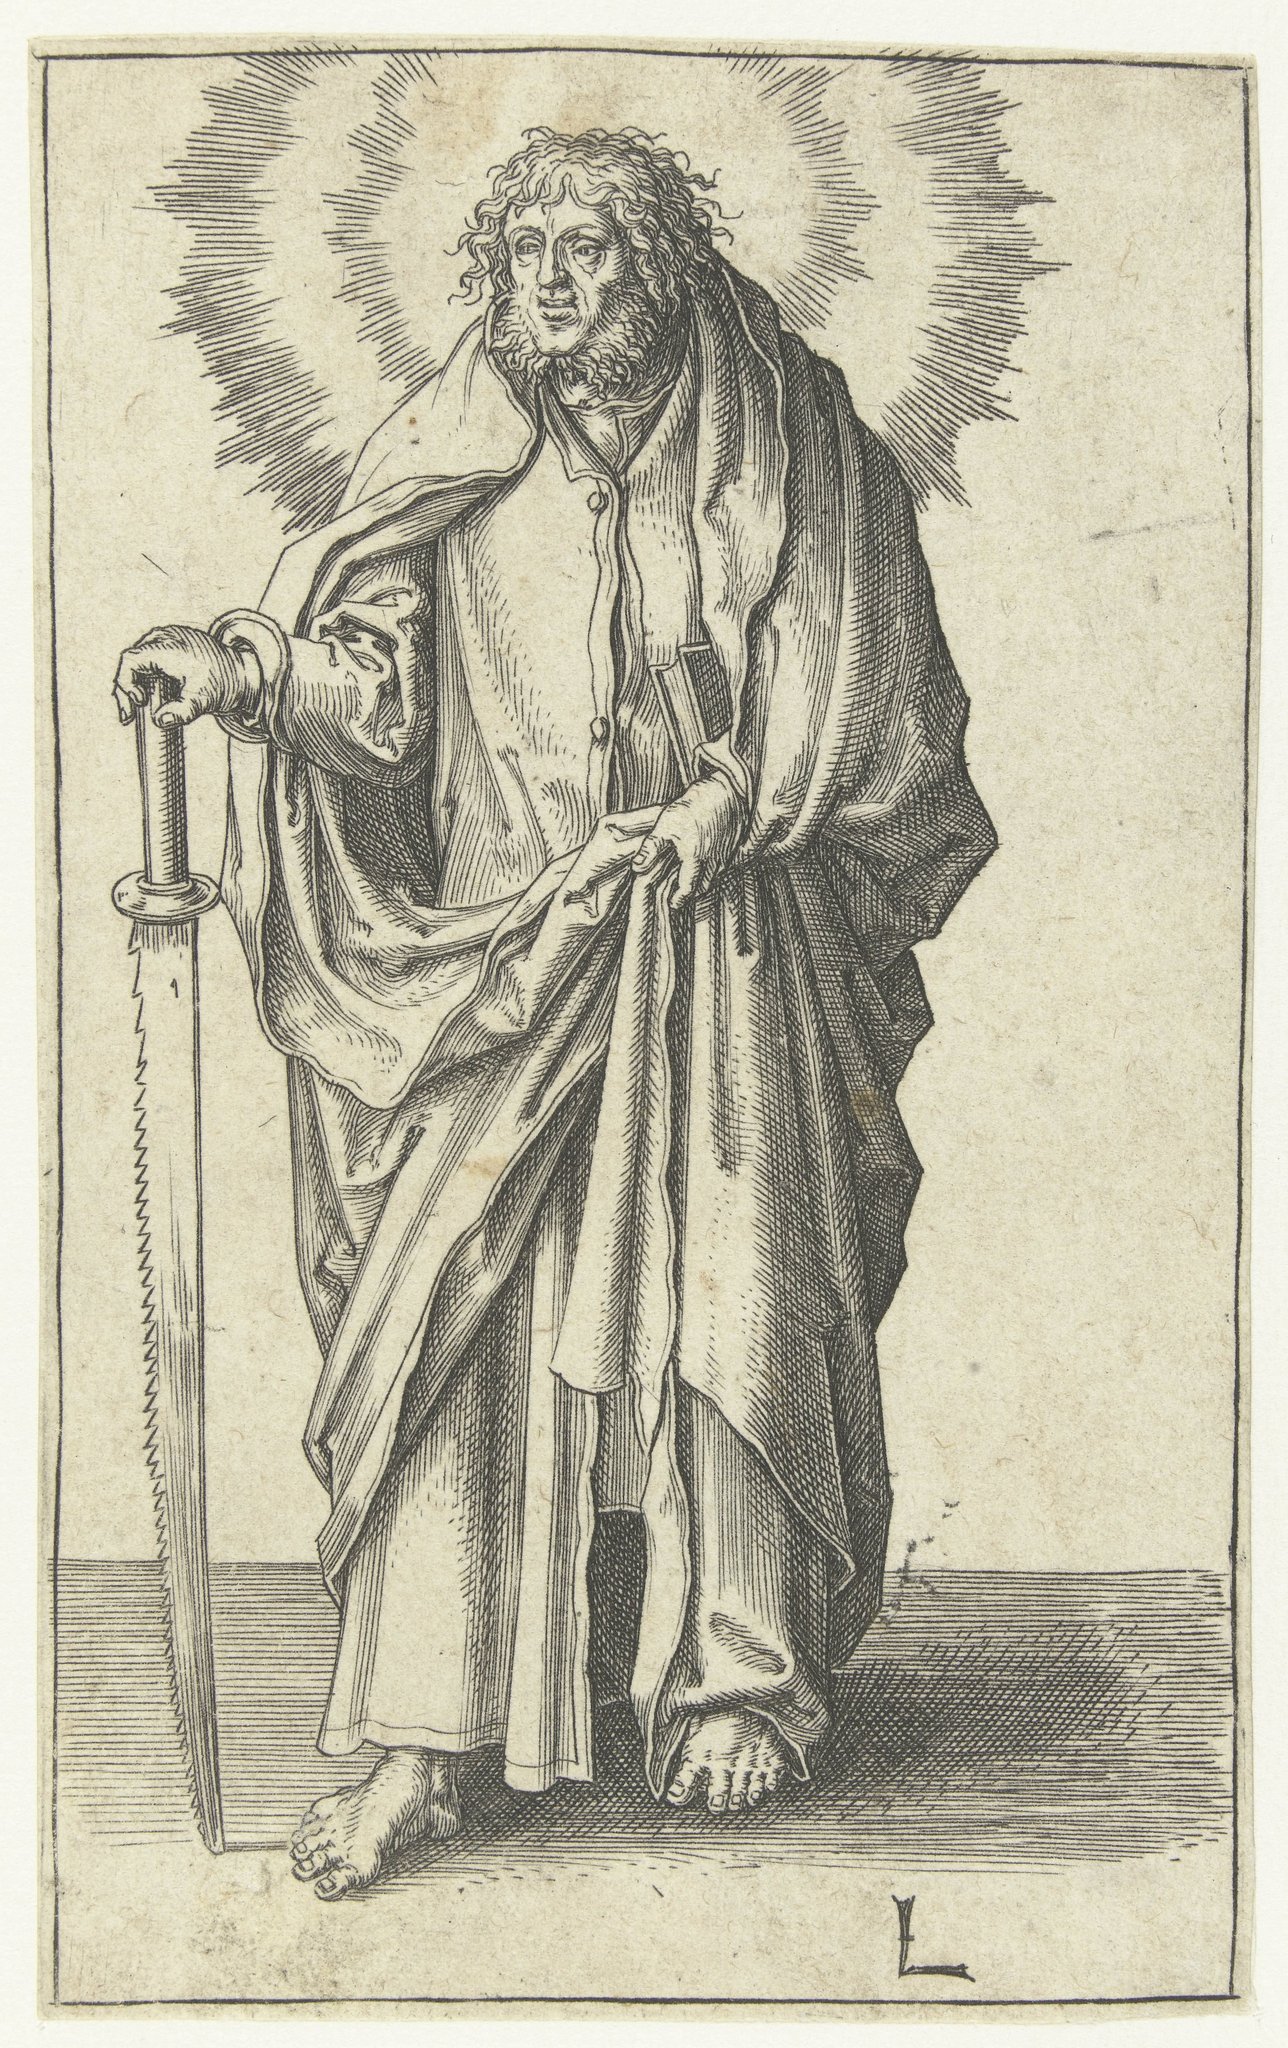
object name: print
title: De apostel Simon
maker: lucas van leyden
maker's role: draughtsman, painter, print maker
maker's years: 1494-1533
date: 1508-1512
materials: paper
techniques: engraving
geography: low countries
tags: the apostle simon zelotes (or simon the canaanite); possible attributes: book, saw, scroll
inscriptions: collector's mark: Lugt 2228a